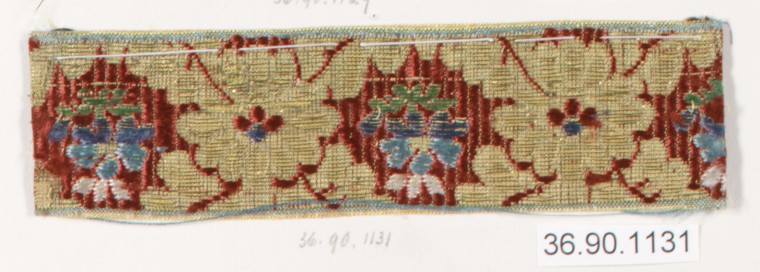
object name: sample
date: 1701-1900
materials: metal thread, silk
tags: flowers